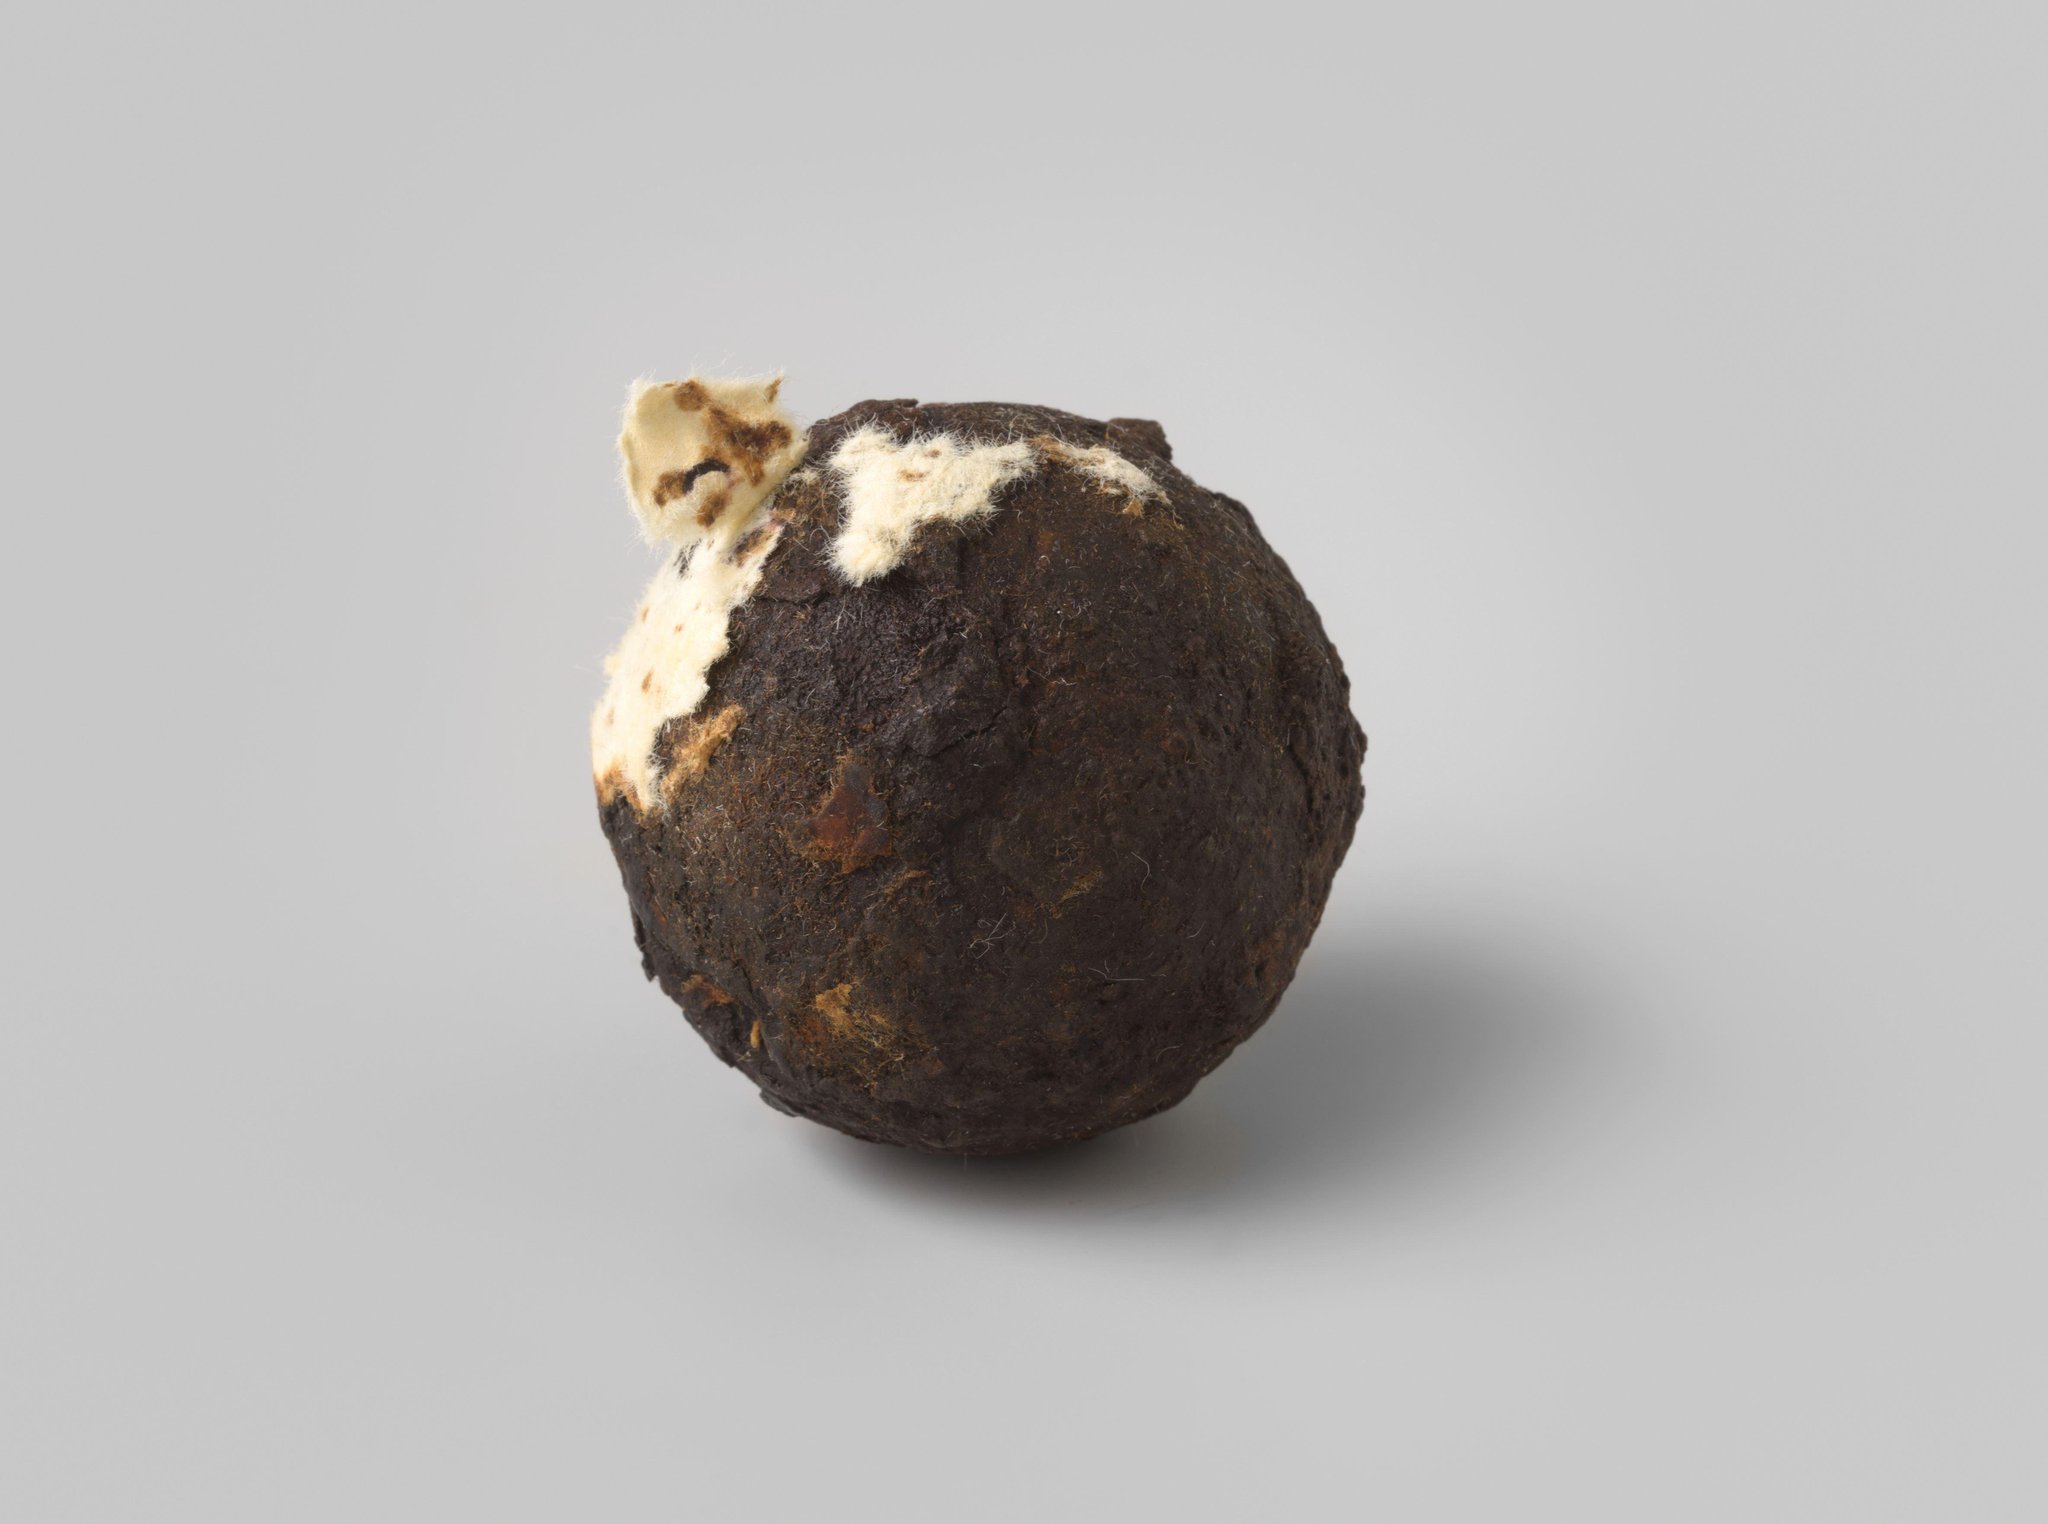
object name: bullet ammunition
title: Kogel uit het wrak van de Oost-Indiëvaarder Hollandia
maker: Anonymous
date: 1700-1743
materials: iron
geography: netherlands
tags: verenigde oostindische compagnie, hollandia (schip), annet